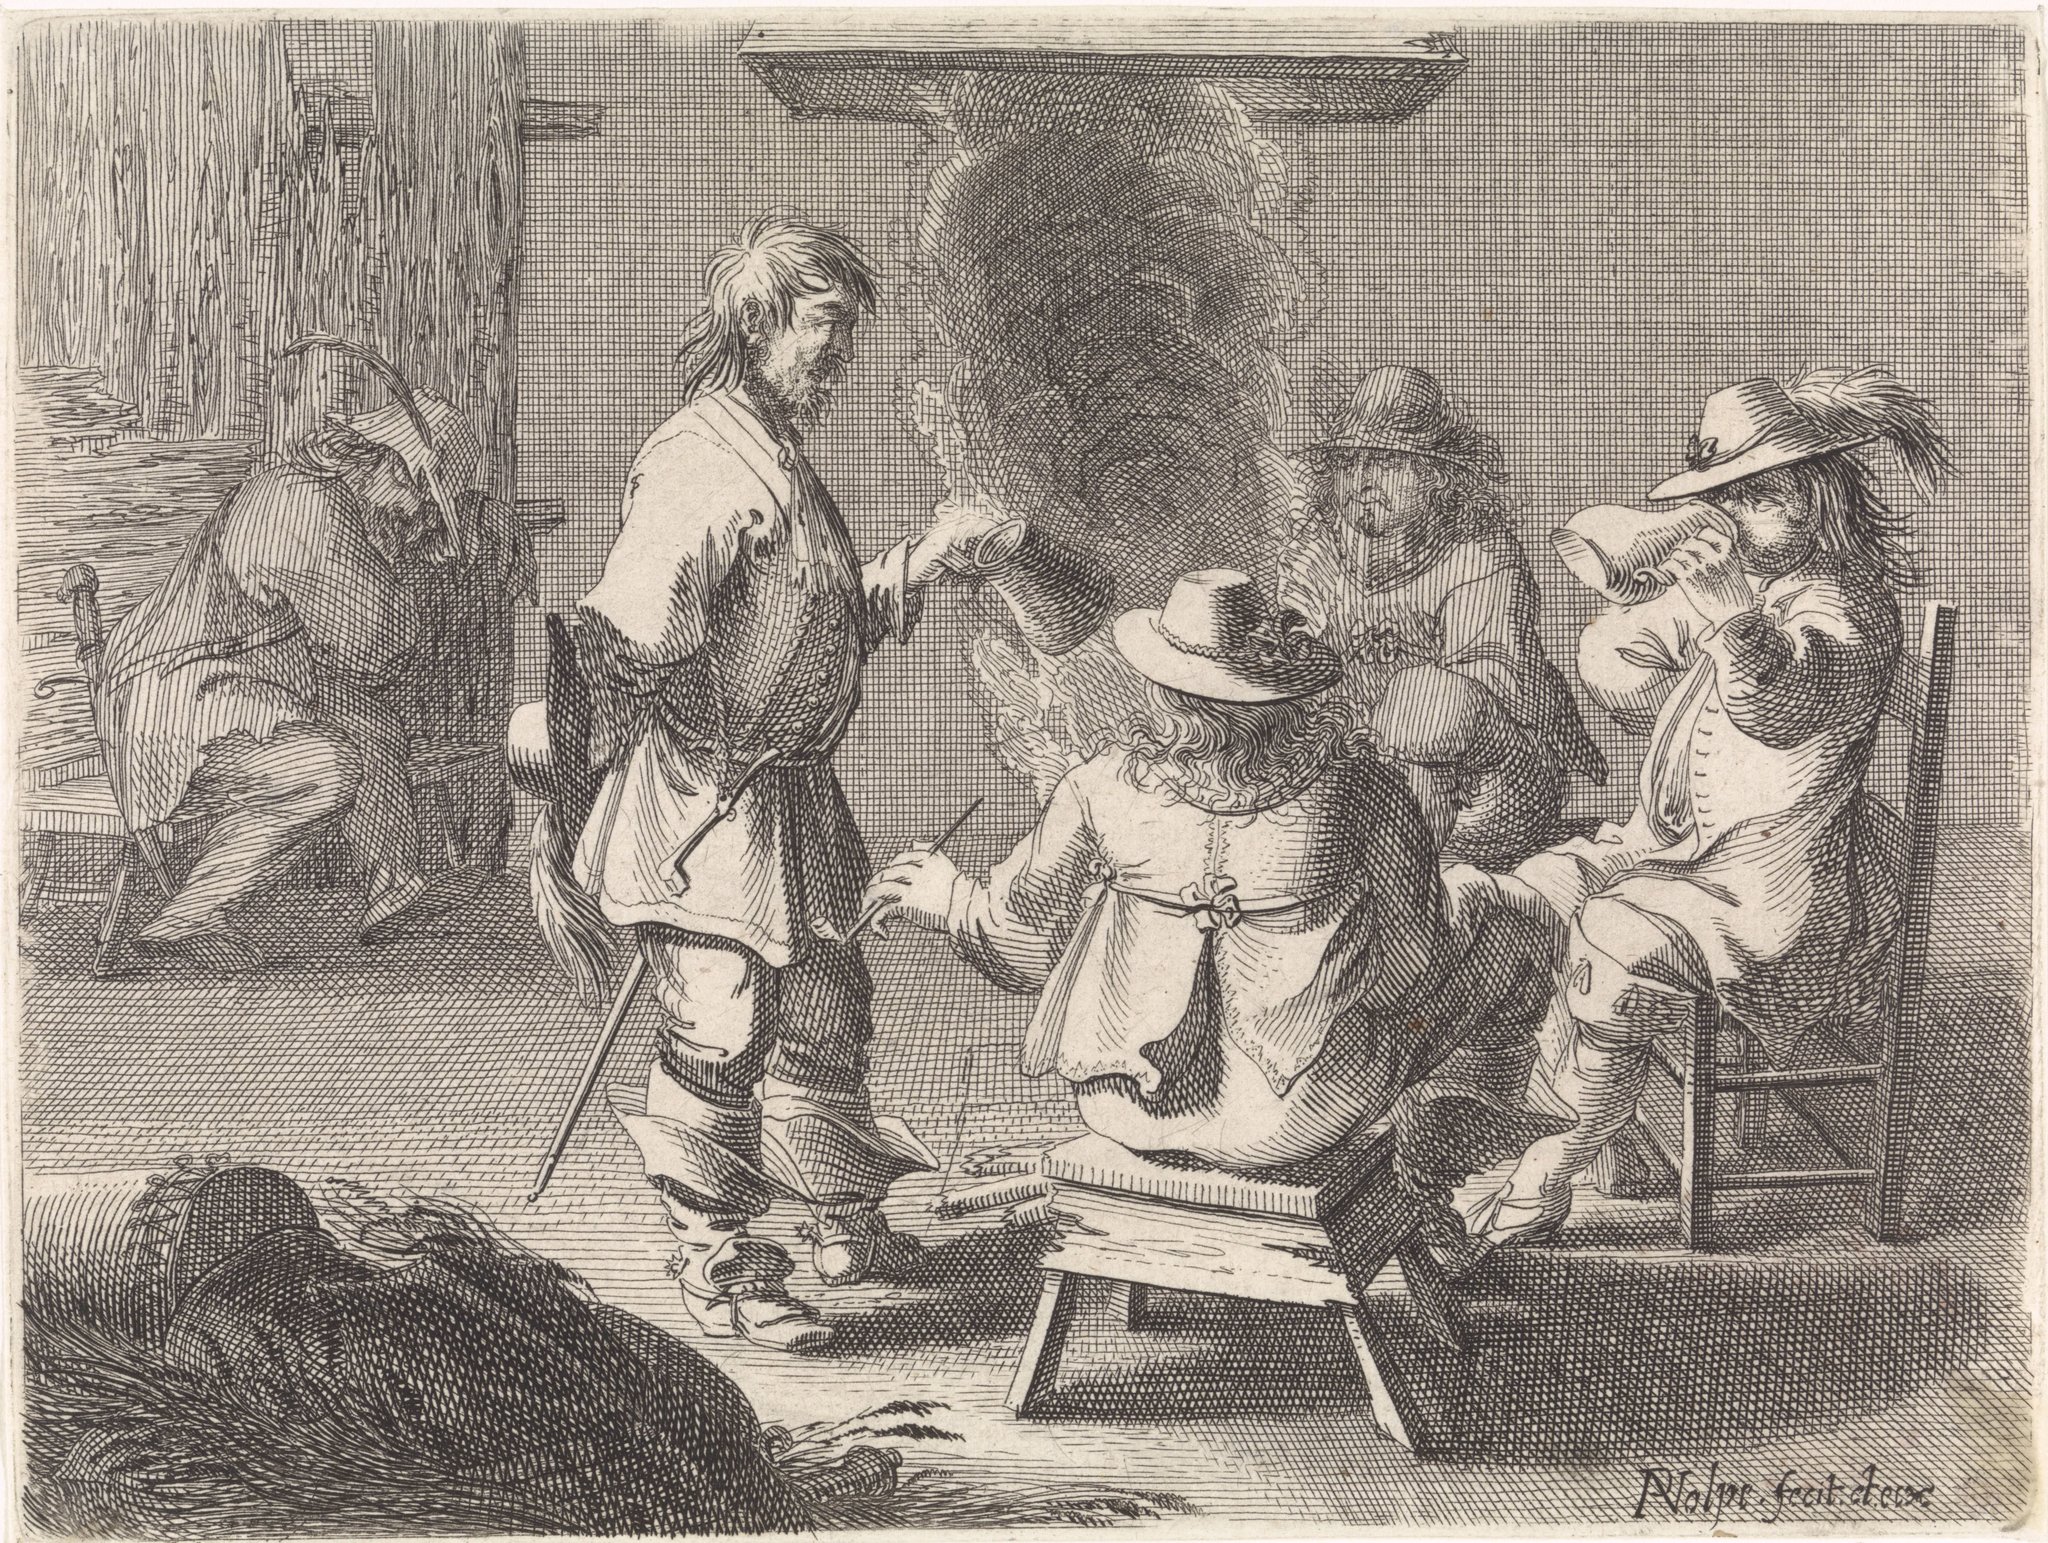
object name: print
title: Mannen rond een vuur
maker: pieter nolpe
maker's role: draughtsman, print maker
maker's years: 1613-1653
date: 1623-1653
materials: paper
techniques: engraving, etching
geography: amsterdam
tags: sleeping in chair (+ variant), pipe ~ tobacco, jar, jug (used as drinking-vessel), open hearth, fire-place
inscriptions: collector's mark: Lugt 240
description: Rond een vuur in een interieur zitten vier mannen, waarvan er twee een kruik in de handen hebben. De man op de rug gezien rookt pijp. Linksachter is een man op een bankje in slaap gevallen.